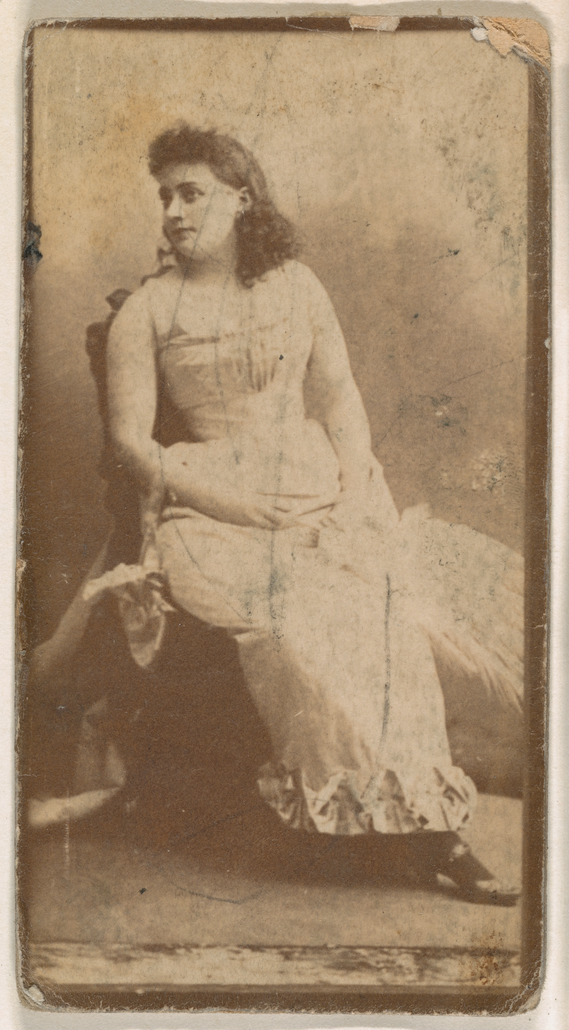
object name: photograph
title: Actress seated with hands on lap, from the Actresses series (N664) promoting Old Fashion Fine Cut Tobacco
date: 1888-1890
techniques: albumen silver print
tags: portraits,women,actresses